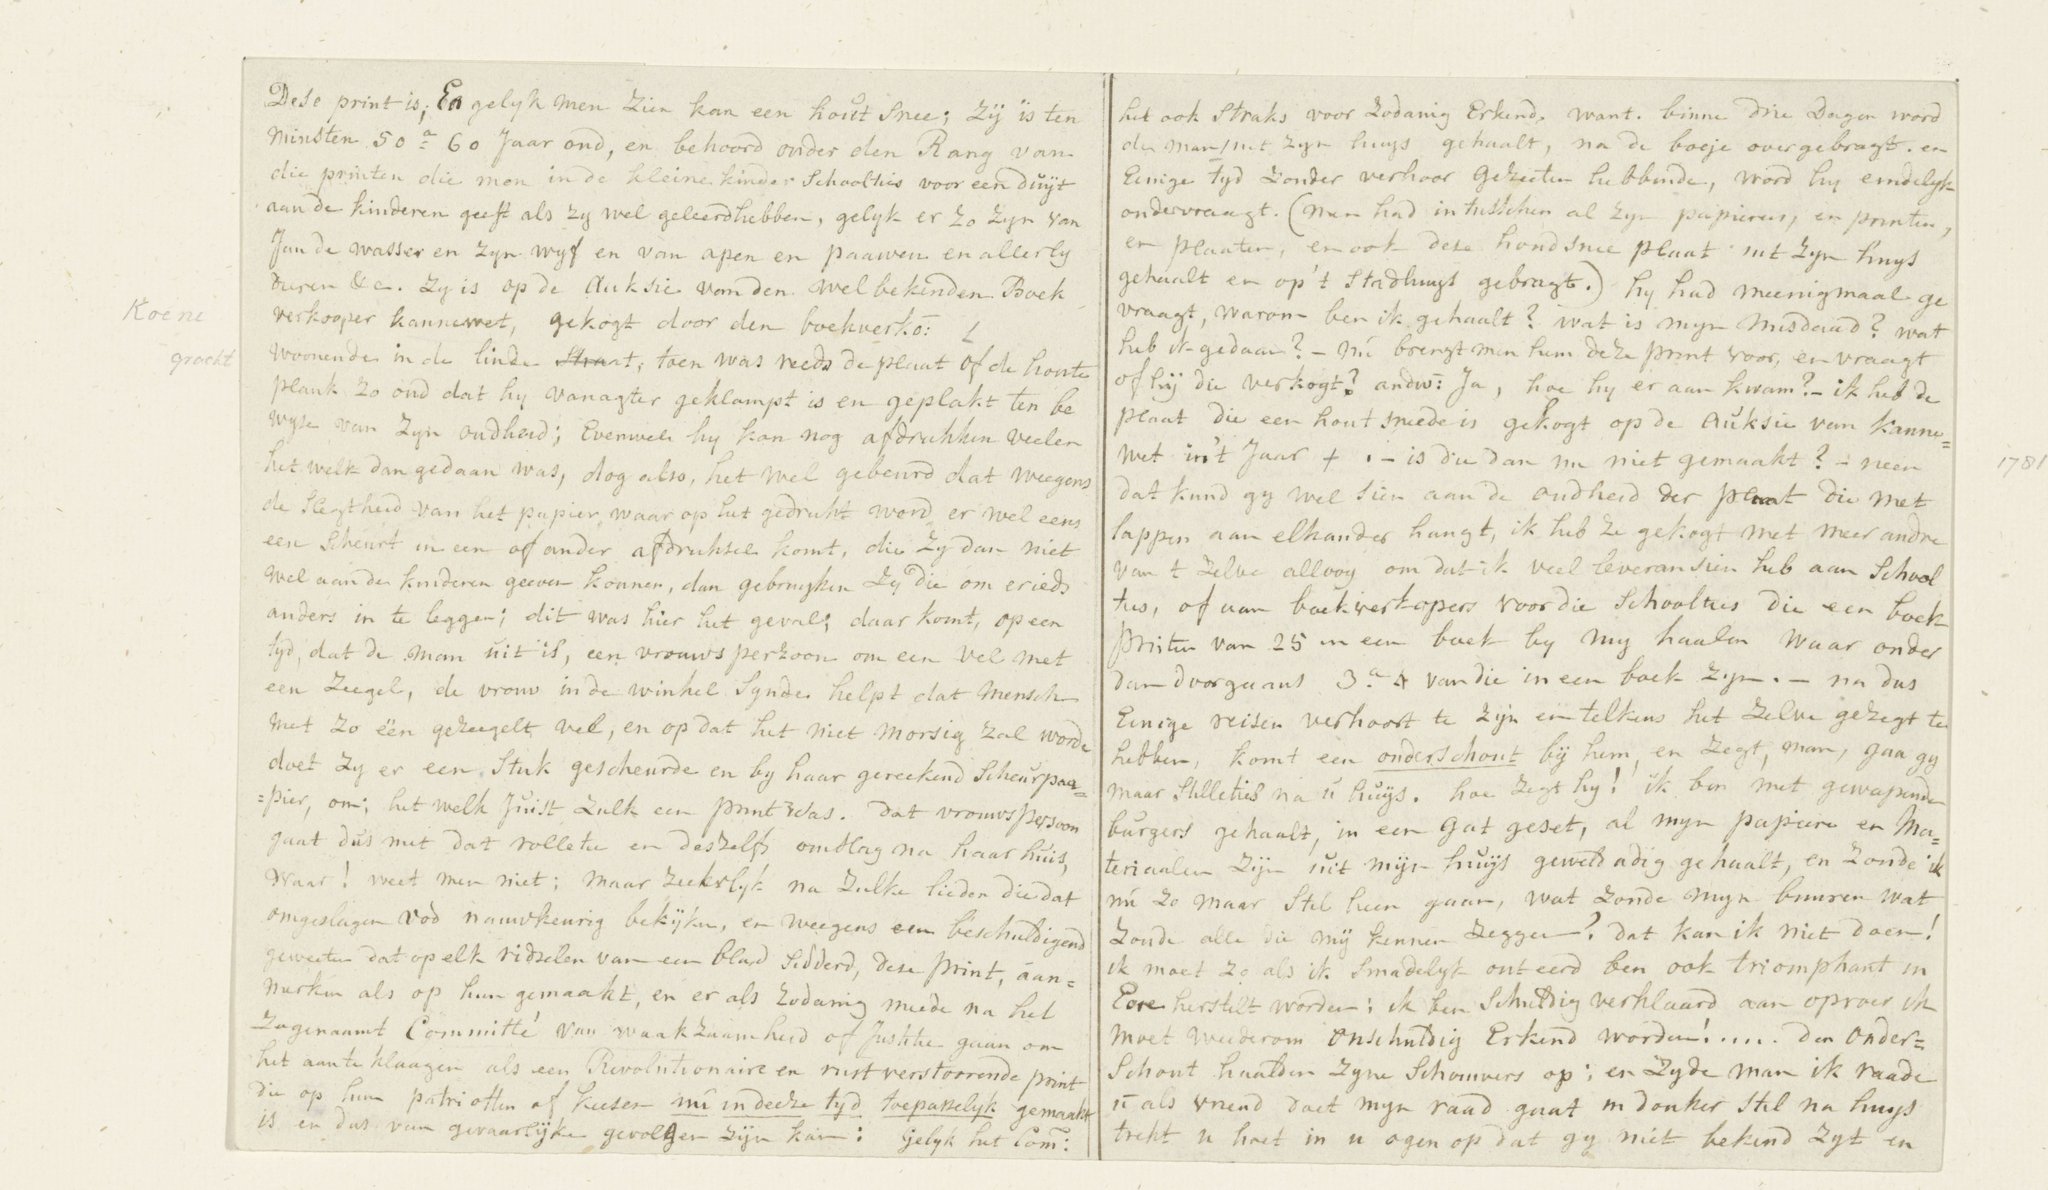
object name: manuscript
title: Handschrift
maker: Anonymous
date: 1830-1850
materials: paper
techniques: writing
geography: netherlands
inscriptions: collector's mark: Lugt 2760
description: Handschrift waarin duidelijk wordt dat de uitgevers van de prent "Kinders wie heeft dit oyt verzonnen / Dat ratten den kryg met de katten begonnen" door S. & W. Koene, in februari 1797 voor het Comité voor Waakzaamheid gedaagd werden op beschuldiging een spotprent op de patriotten te hebben uitgegeven. Recto en verso beschreven.